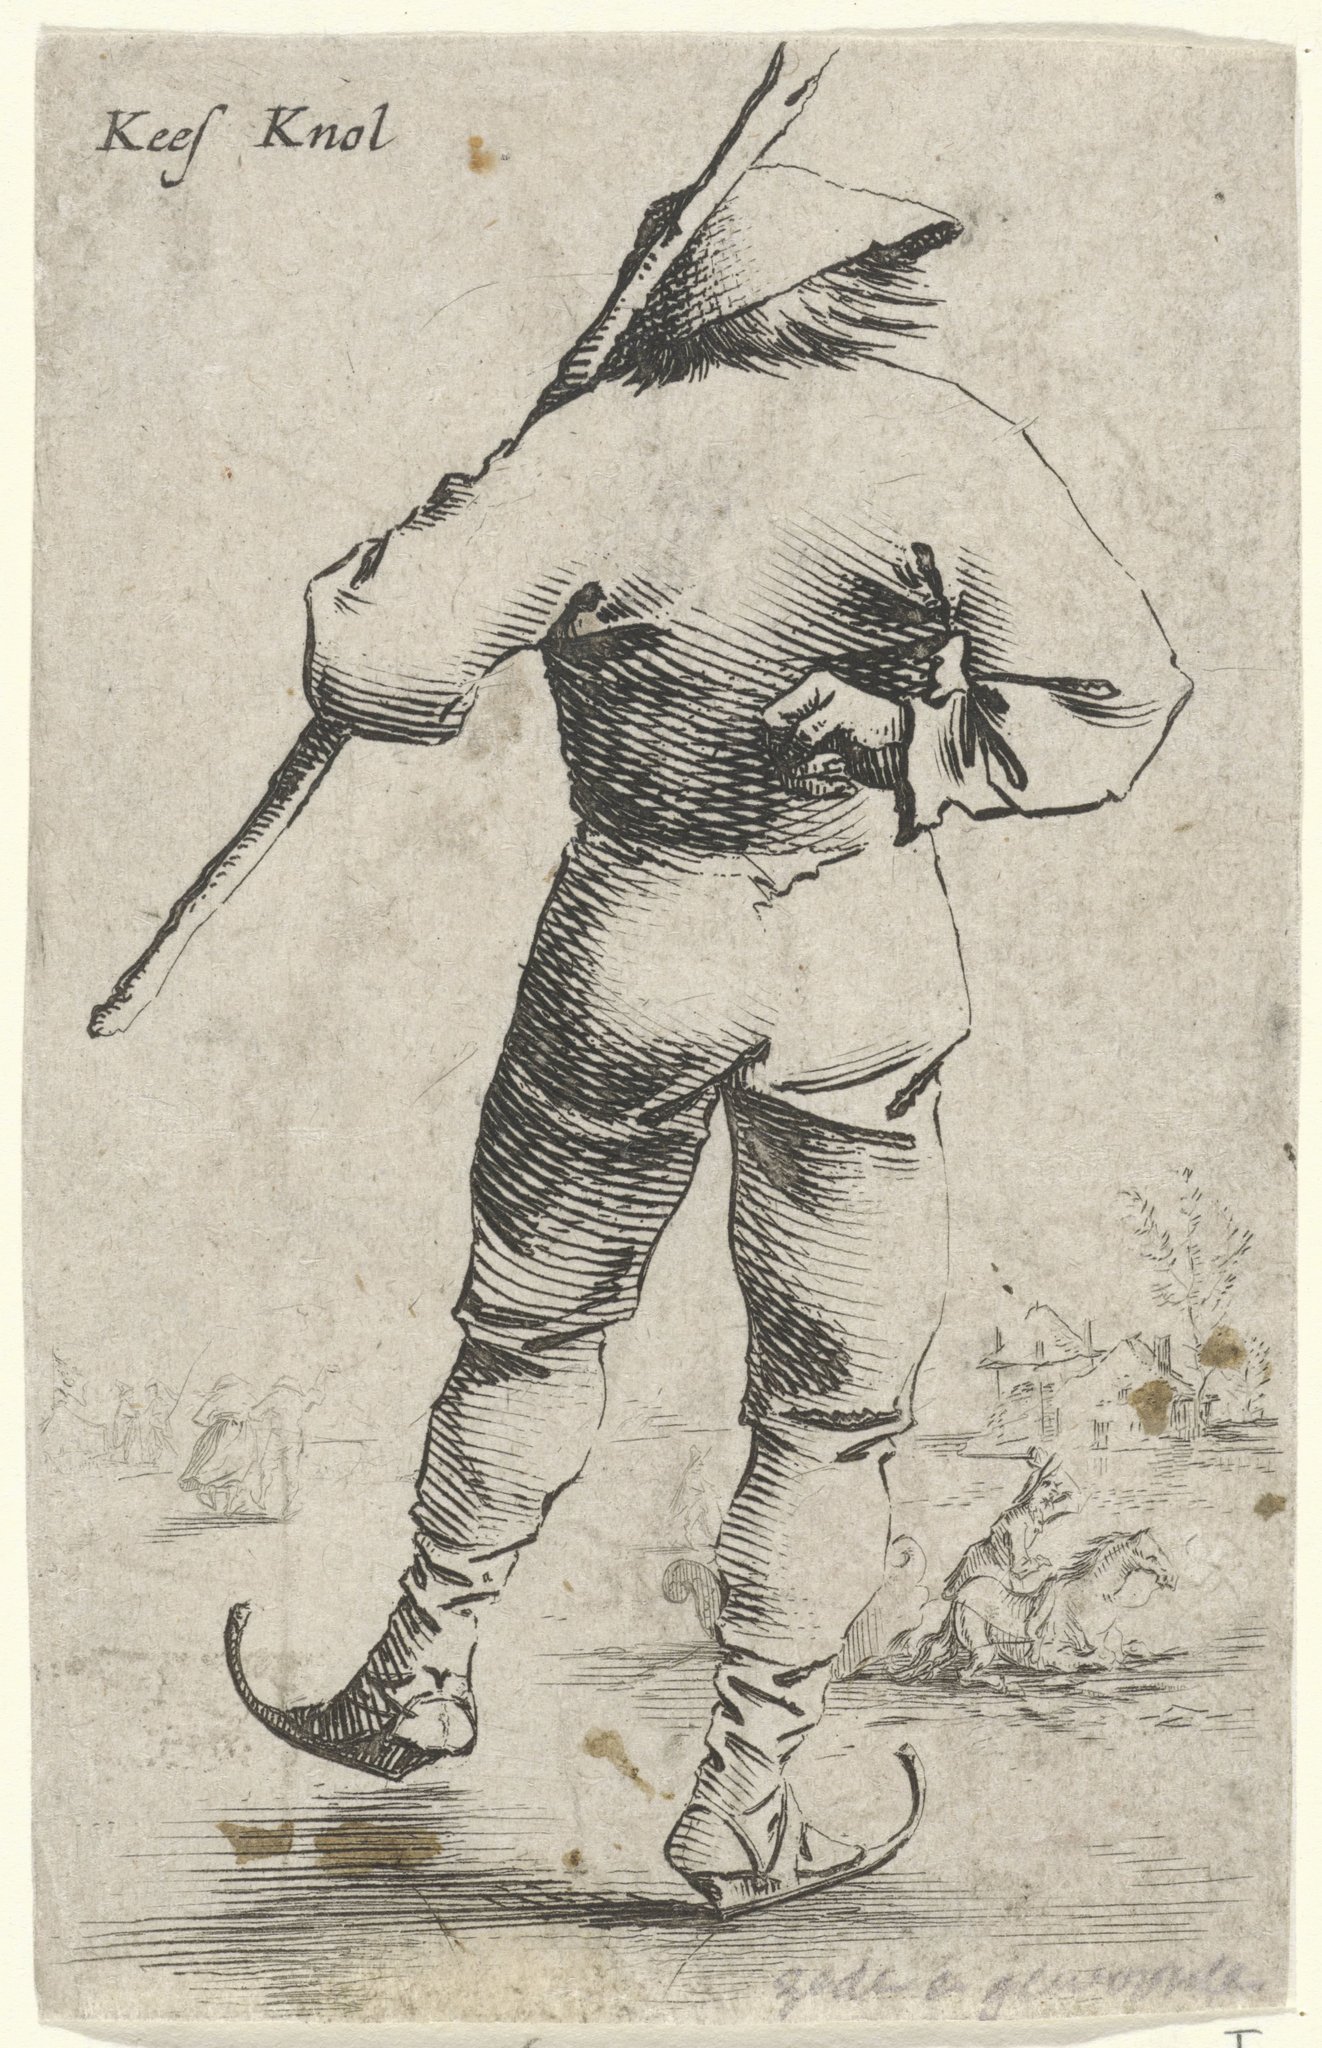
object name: print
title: Schaatsende man, van achter gezien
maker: salomon savery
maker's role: print maker, publisher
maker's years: 1594-1683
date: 1630-1665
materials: paper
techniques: engraving, etching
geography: amsterdam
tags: skates (winter sports)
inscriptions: collector's mark: Lugt 240, inscription: ‘zeden en gewoonten’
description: De prent maakt deel uit van een twaalfdelige serie prenten met voorstellingen van boeren.